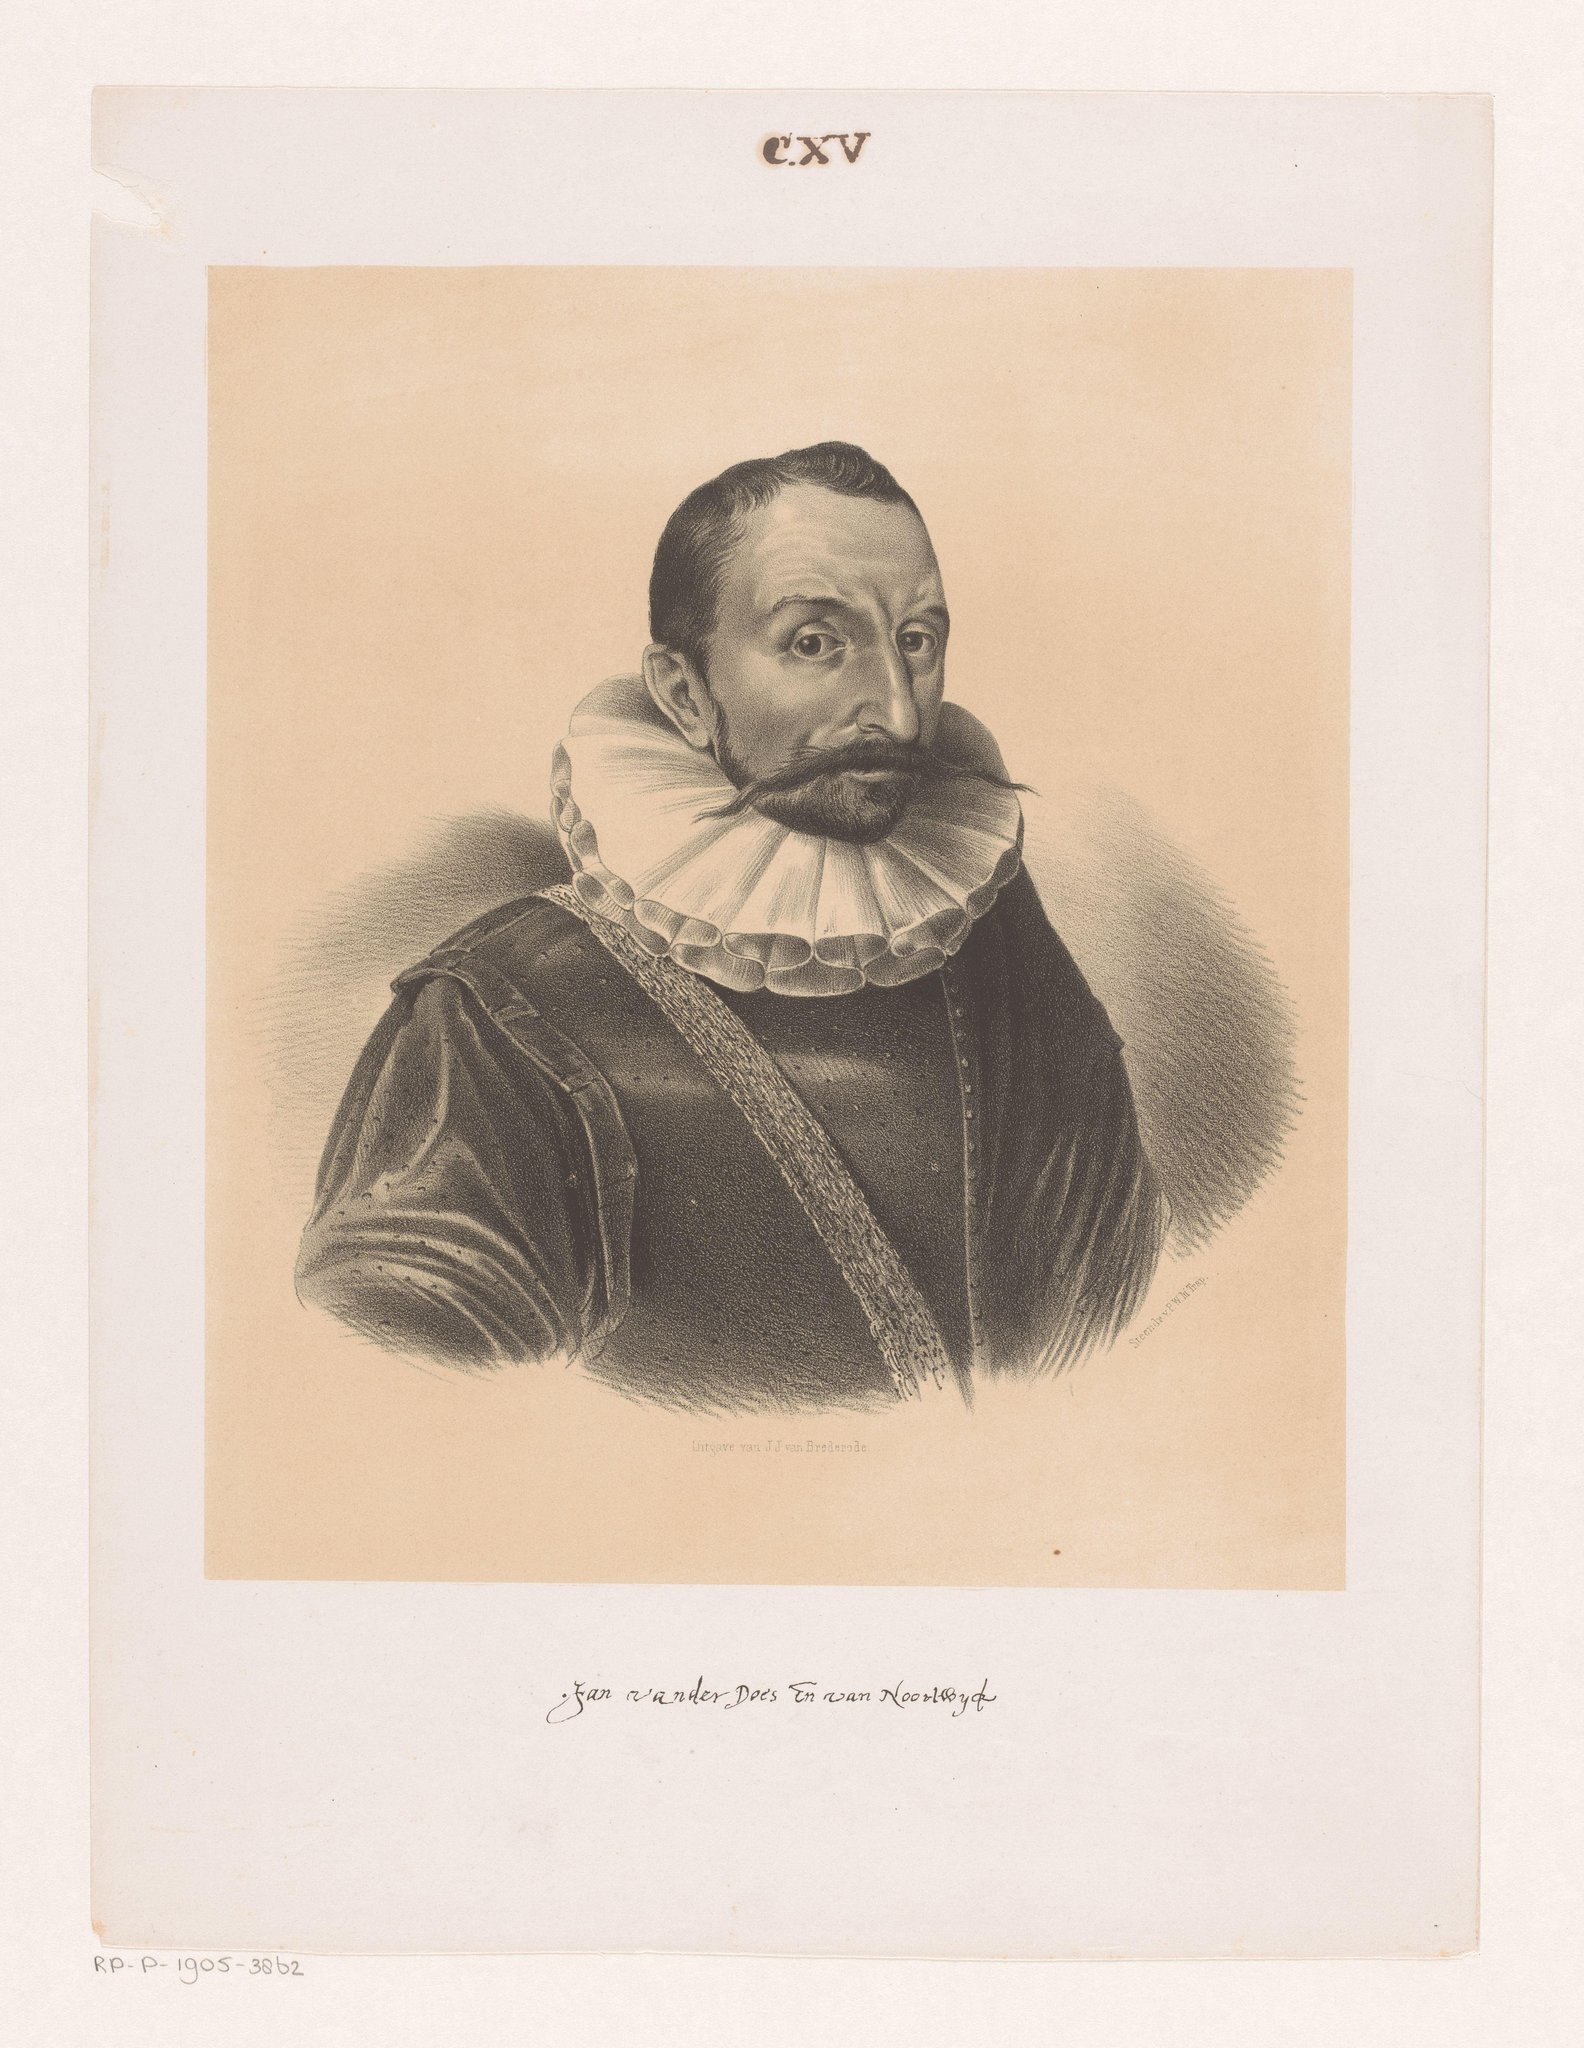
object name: print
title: Jan van der Does en van Noordwijck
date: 1849-1905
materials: paper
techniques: tone lithography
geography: leiden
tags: historical persons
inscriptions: collector's mark: Lugt 2228